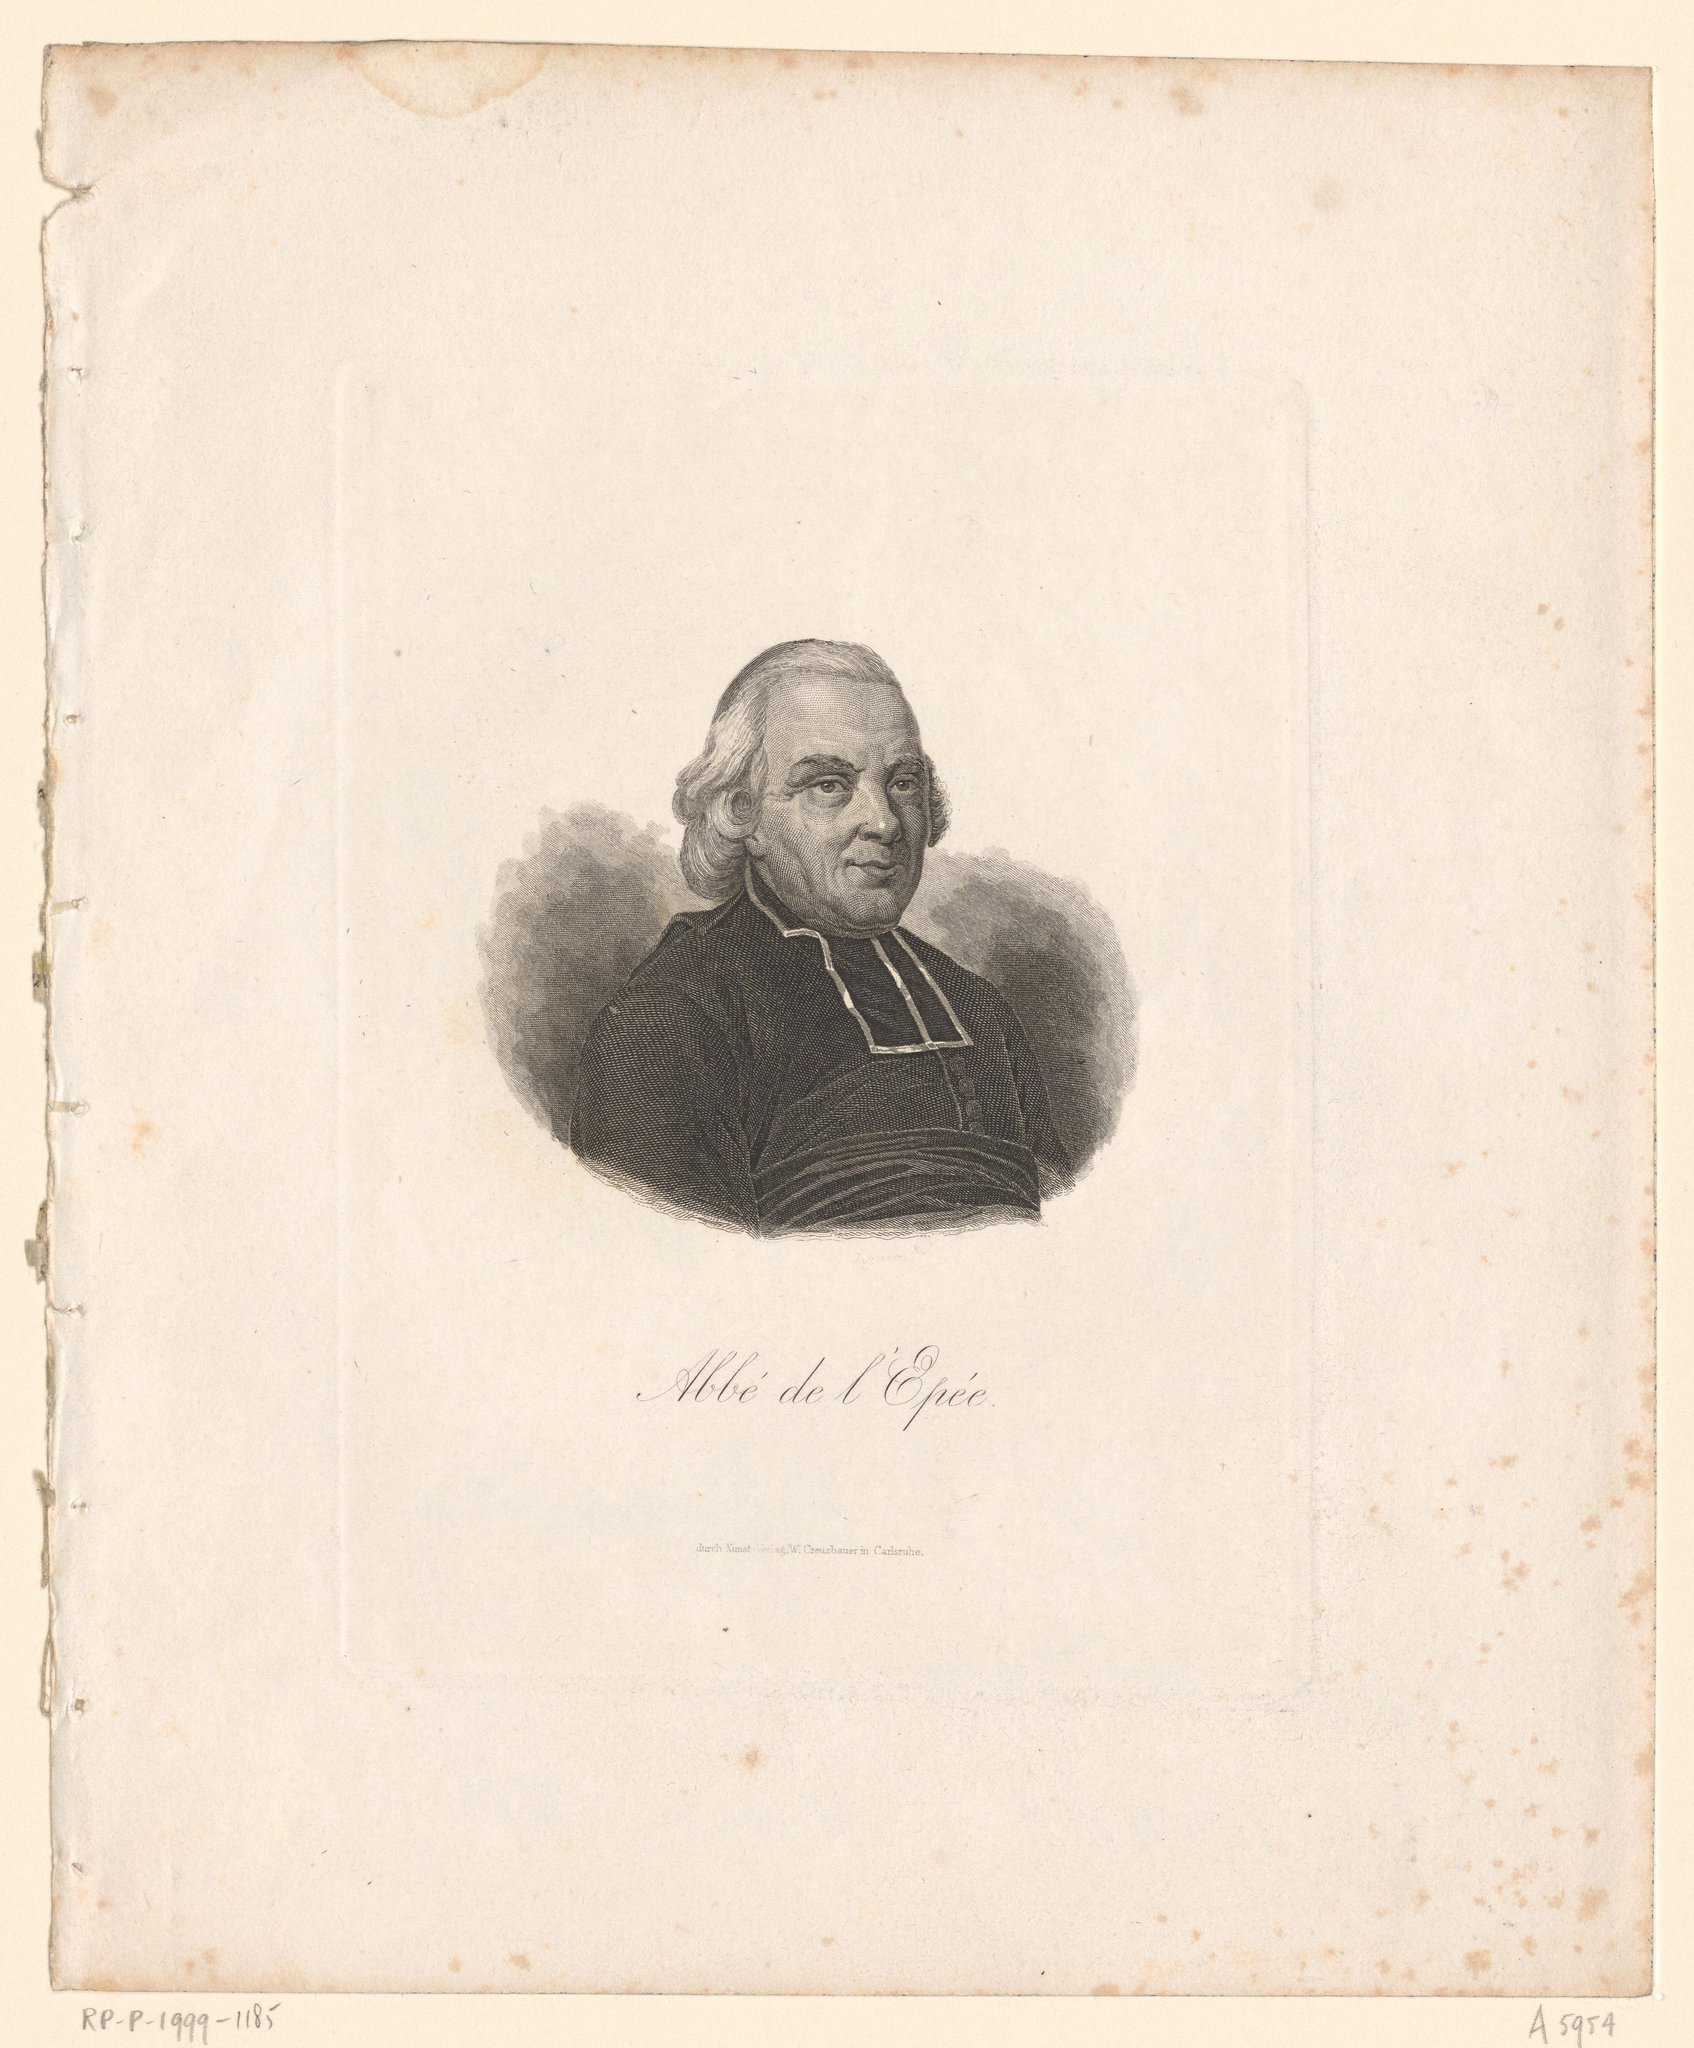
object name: print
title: Portret van Charles-Michel de l'Épée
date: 1831-1880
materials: paper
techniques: etching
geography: france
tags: paris, historical persons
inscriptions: collector's mark: Lugt 2228, collector's mark: Lugt 2760